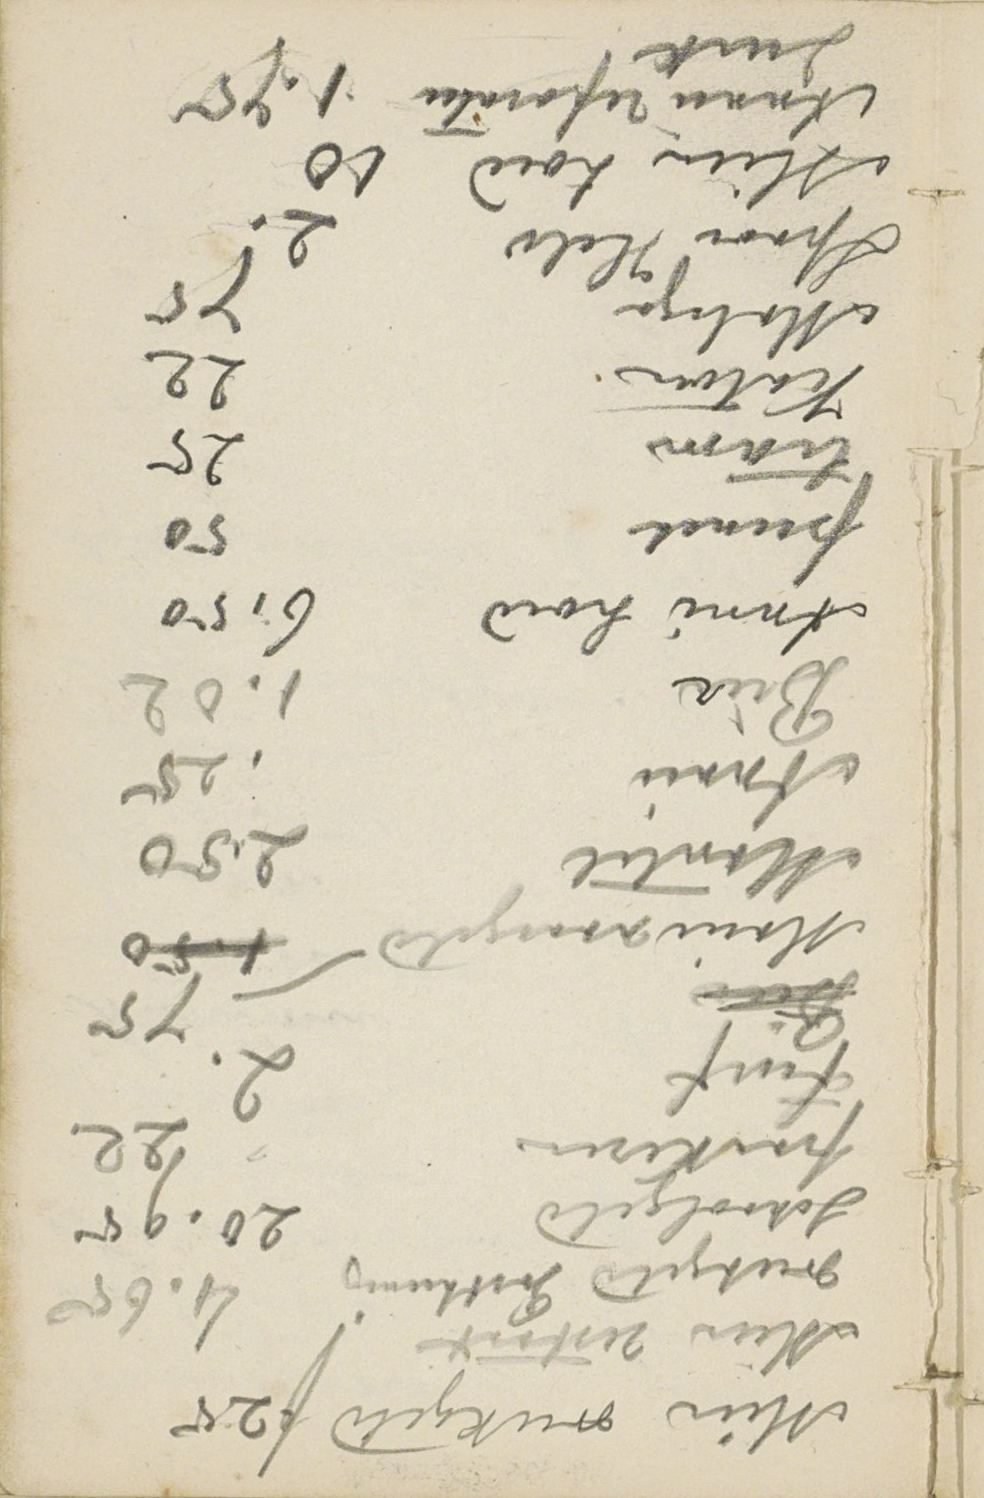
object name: sketchbook leaf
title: Lijst met uitgaven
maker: willem koekkoek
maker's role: draughtsman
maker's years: 1839-1895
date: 1849-1895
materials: paper, pencil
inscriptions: annotation: ‘Mein weekgeld f25/ mein restant/ weekgeld posthumis 4.65/ schoolgeld 20.95/ parkeren 22/ turf 2./ [...]’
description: Blad 54 verso uit een schetsboek met 57 bladen.